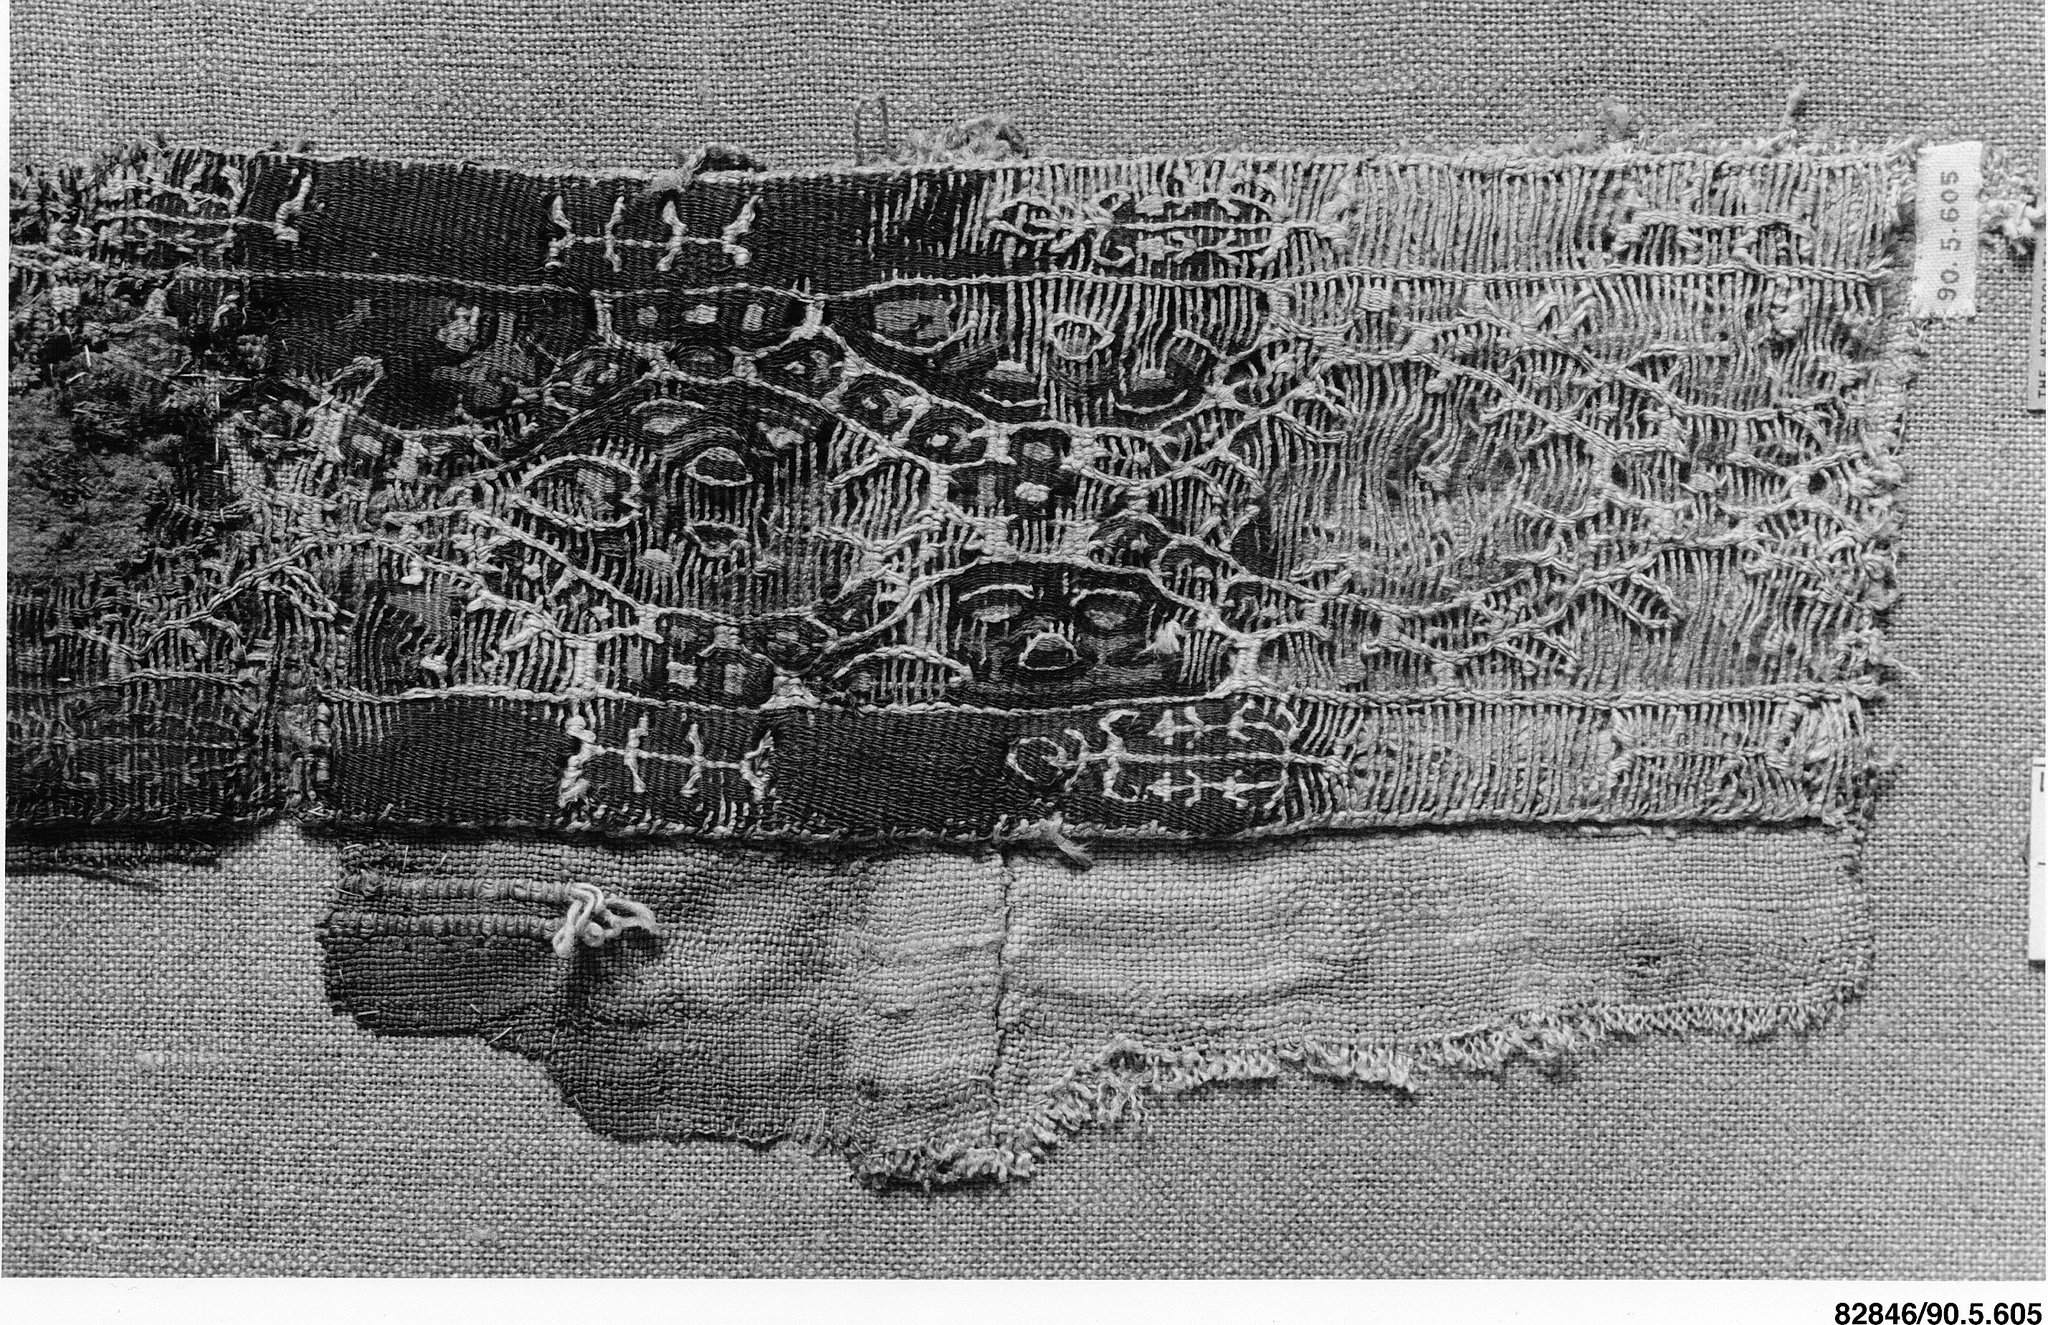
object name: textile fragment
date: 401-600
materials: linen, wool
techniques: weave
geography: egypt